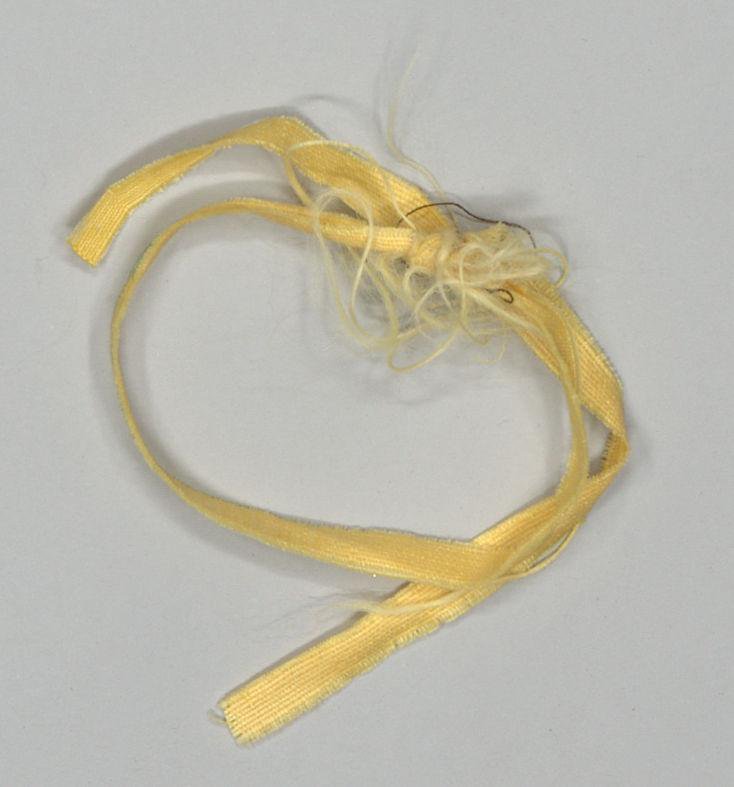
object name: bed covering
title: Fragment van een bedgarnituur van gele gewaterde wol met groen passement en afhangende klosjes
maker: Anonymous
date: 1795-1815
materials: wool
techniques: moire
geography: northern netherlands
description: Fragment van een bedgarnituur van gele gewaterde wol, omboord met groen passement met een geel motief en met een groen en geel boordsel met afhangende klosjes die met gele en groene zijde zijn omwonden.